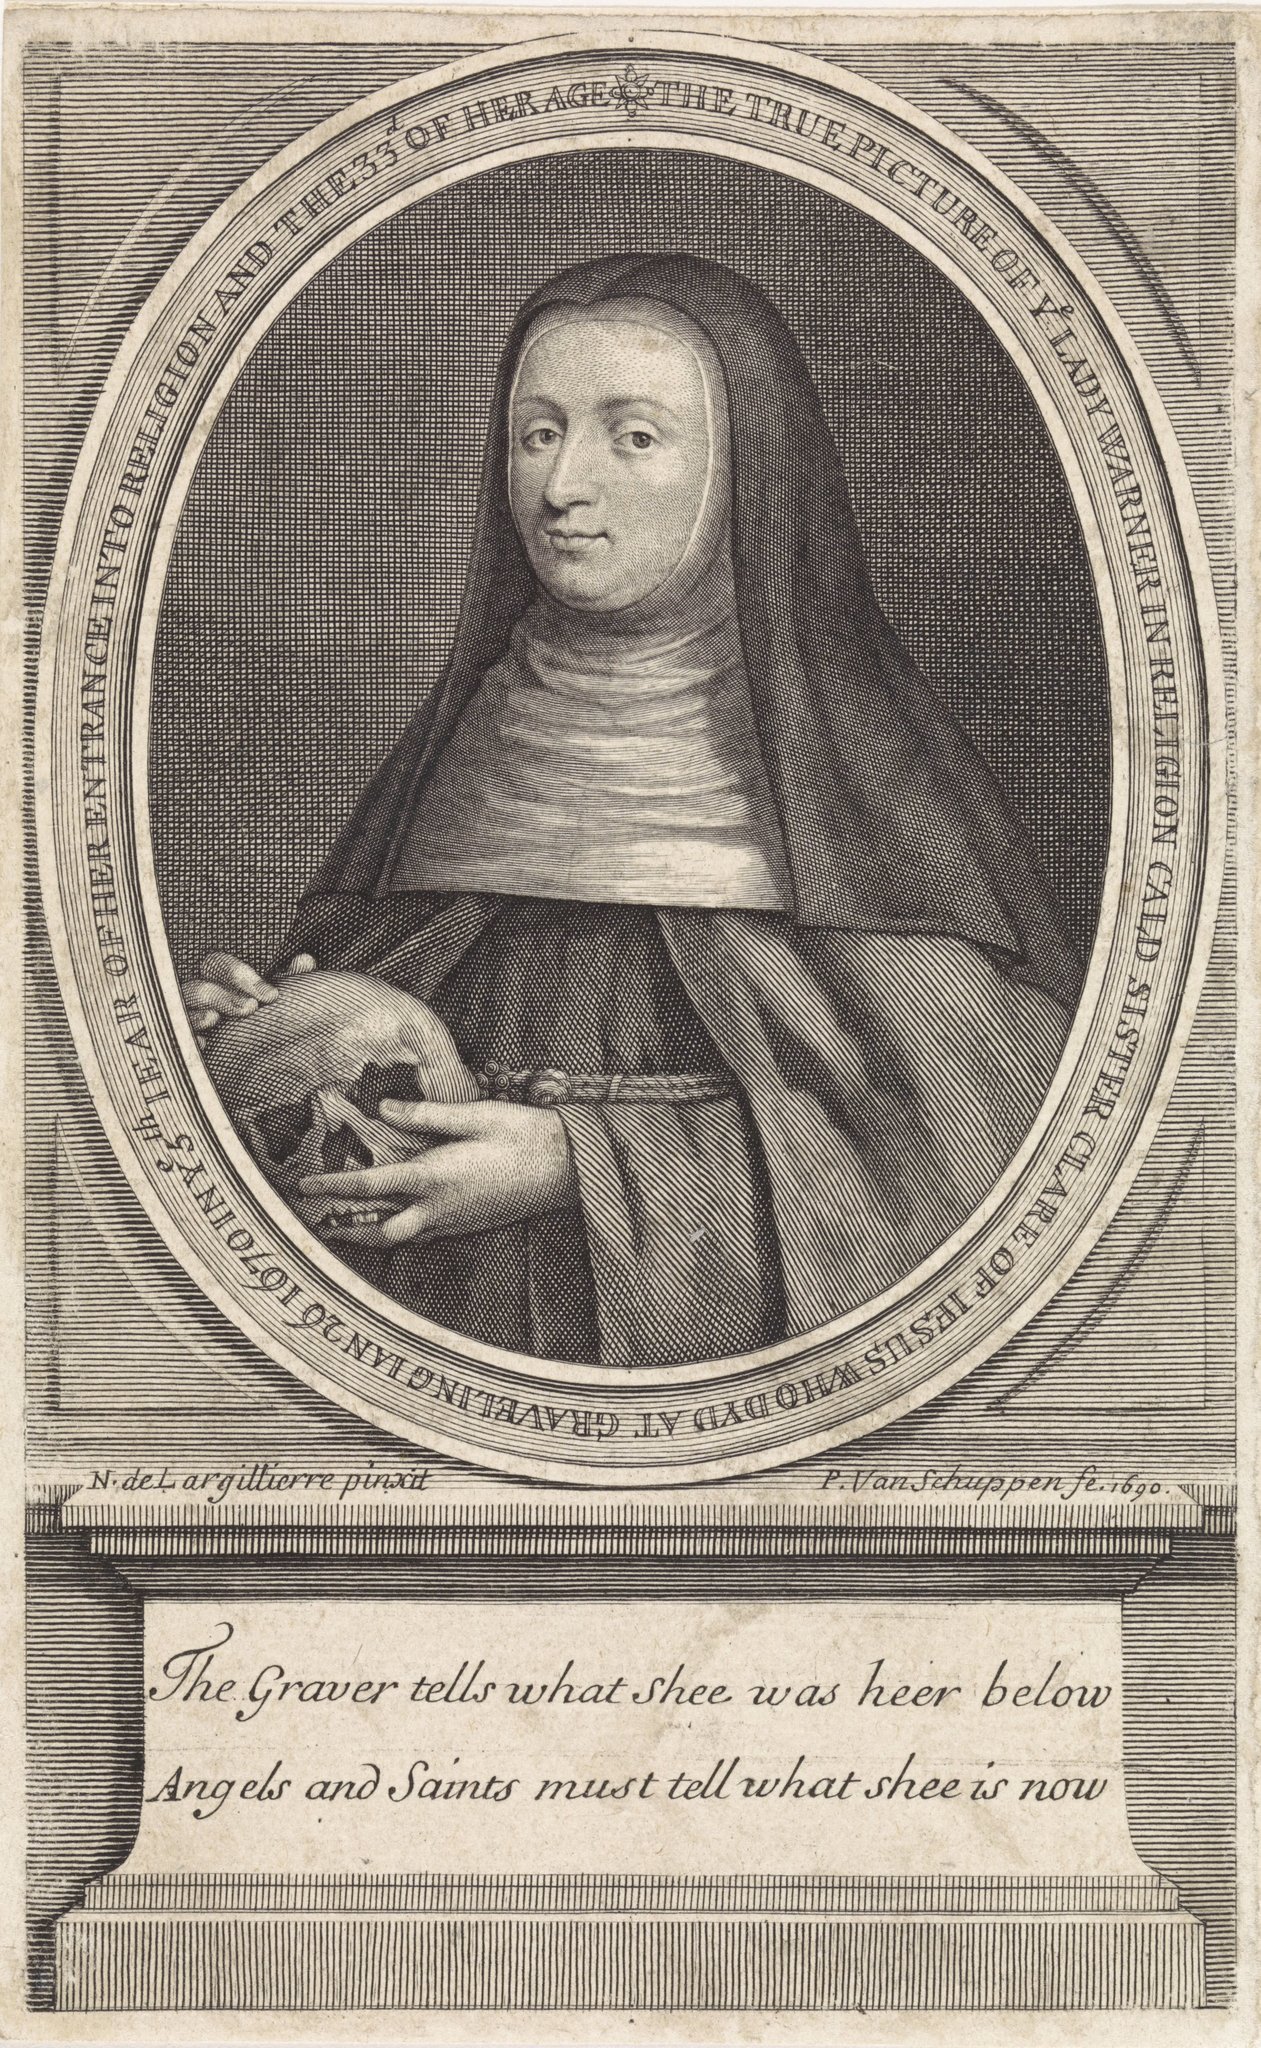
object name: print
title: Portret van Lady Trevor Warner als non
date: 1610-1690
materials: paper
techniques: engraving, etching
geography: paris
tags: skull as symbol of 'vanitas'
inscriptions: collector's mark: Lugt 2228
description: Portret van Lady Trevor Warner als non. In haar handen houdt zij een schedel. In de ovale omlijsting staan haar naam, de naam waaronder zij intrad in het klooster en haar sterfdatum. Op het piëdestal een gedicht in het Engels.